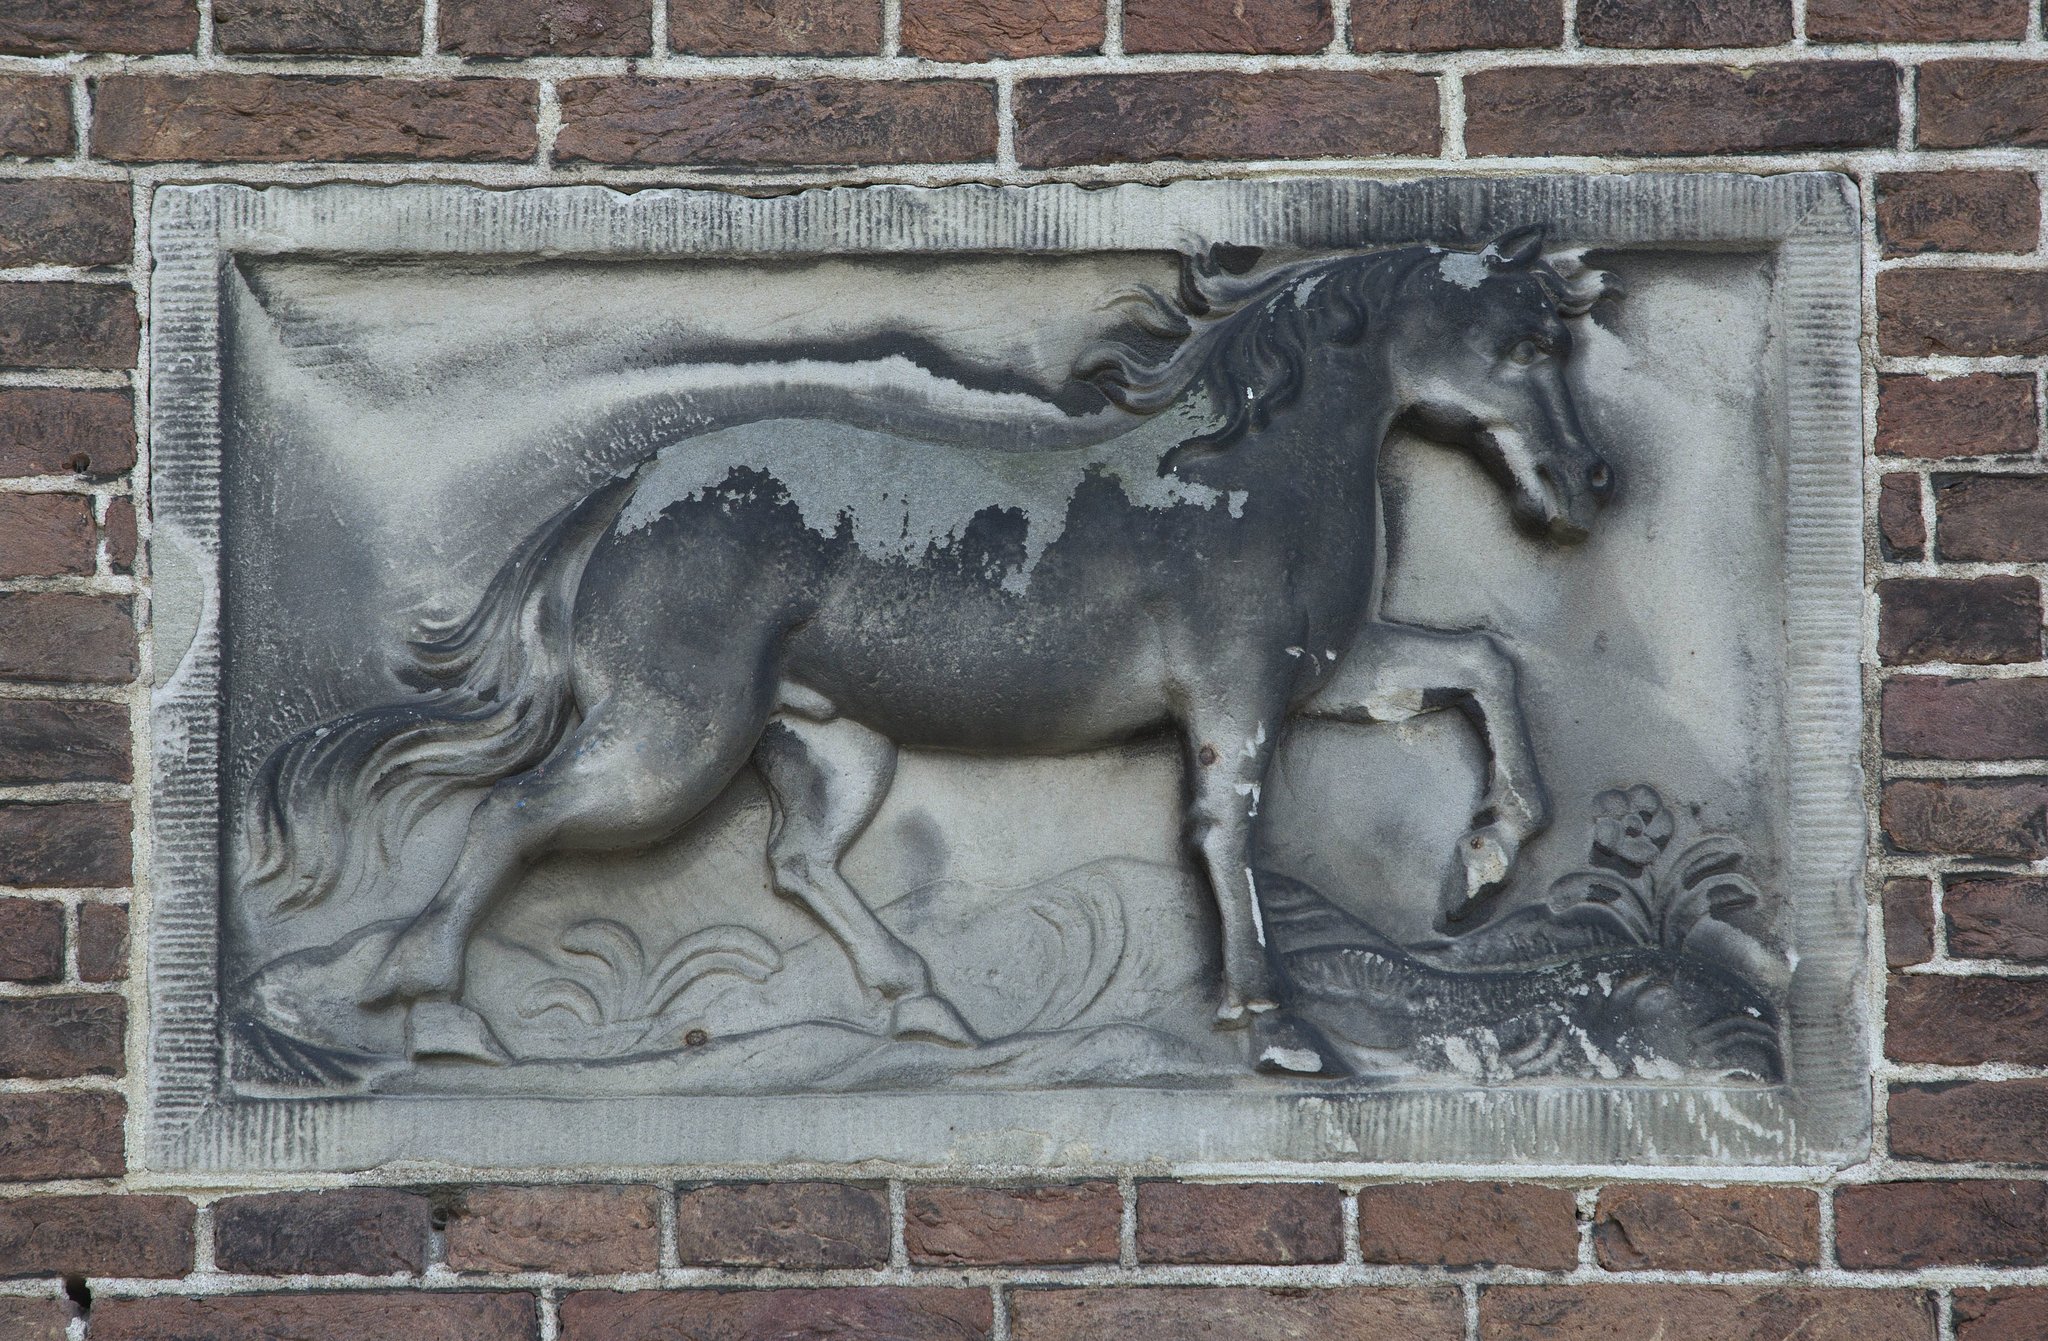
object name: gable stone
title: Gevelsteen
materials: stone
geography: amsterdam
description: Een zandstenen gevelsteen met een lopend paard. Afkomstig van het Rembrandtplein.